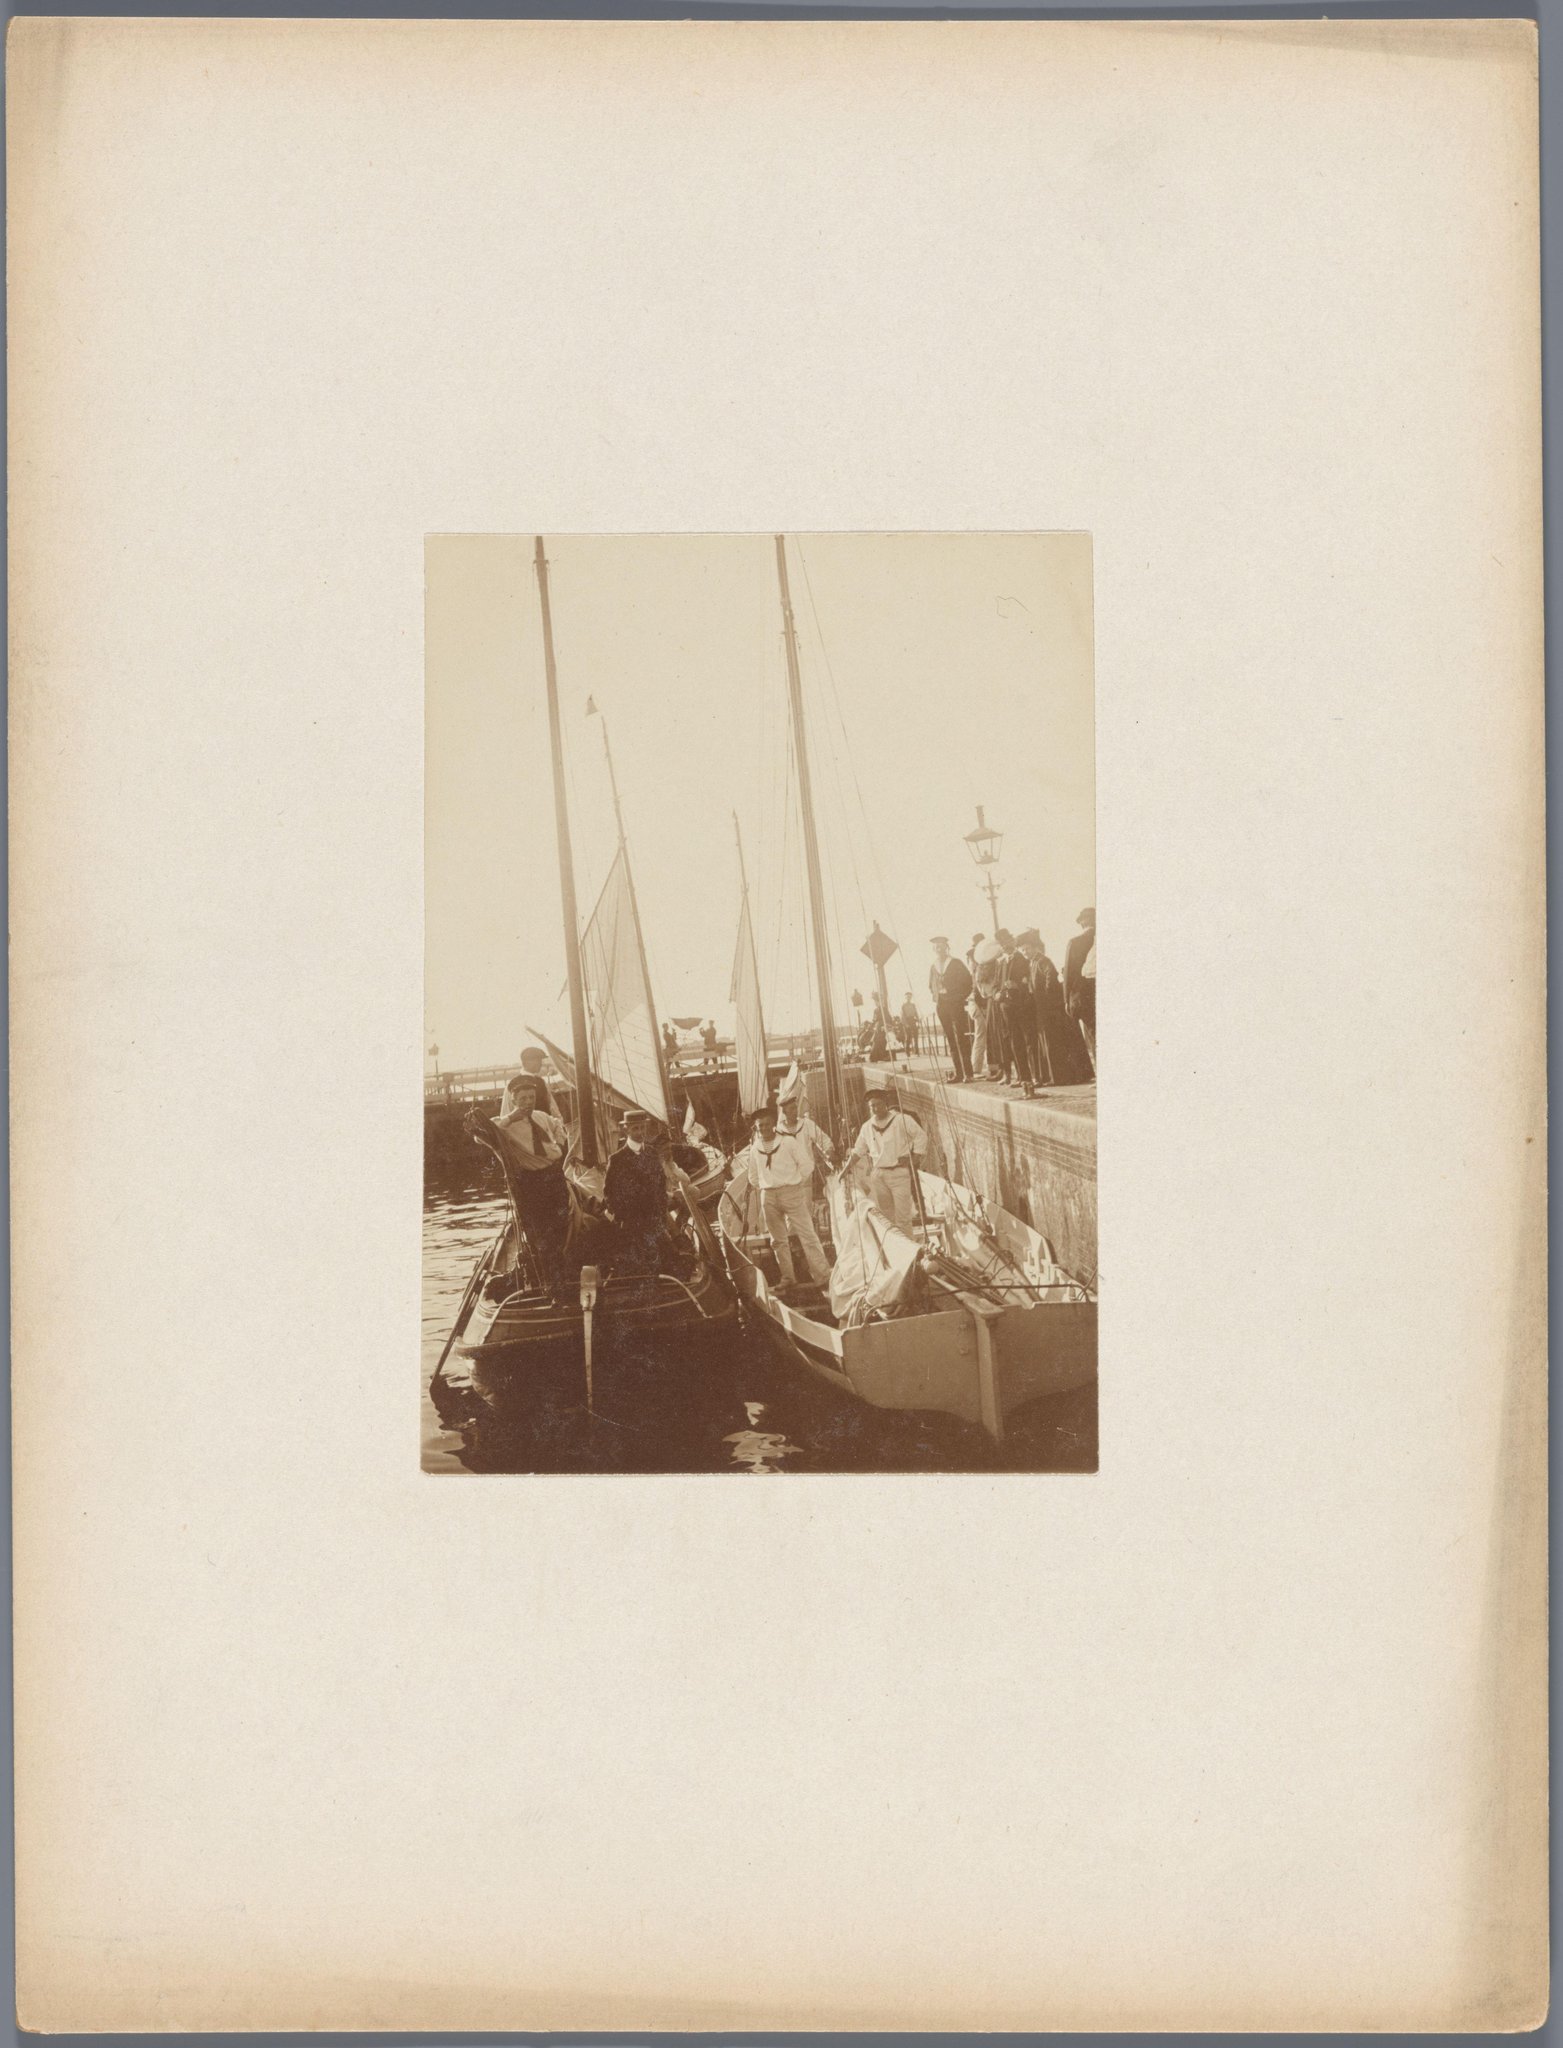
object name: photograph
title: Zeilboten aan een kade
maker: Anonymous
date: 1907-1910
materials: cardboard, photographic support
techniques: collodion silver print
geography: netherlands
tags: sailing-ship, sailing-boat, quay, netherlands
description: Zeilboten aan een kade. Onderdeel van het losbladige fotoalbum met 39 foto's van een reis door Nederland, ca. 1907-1910.